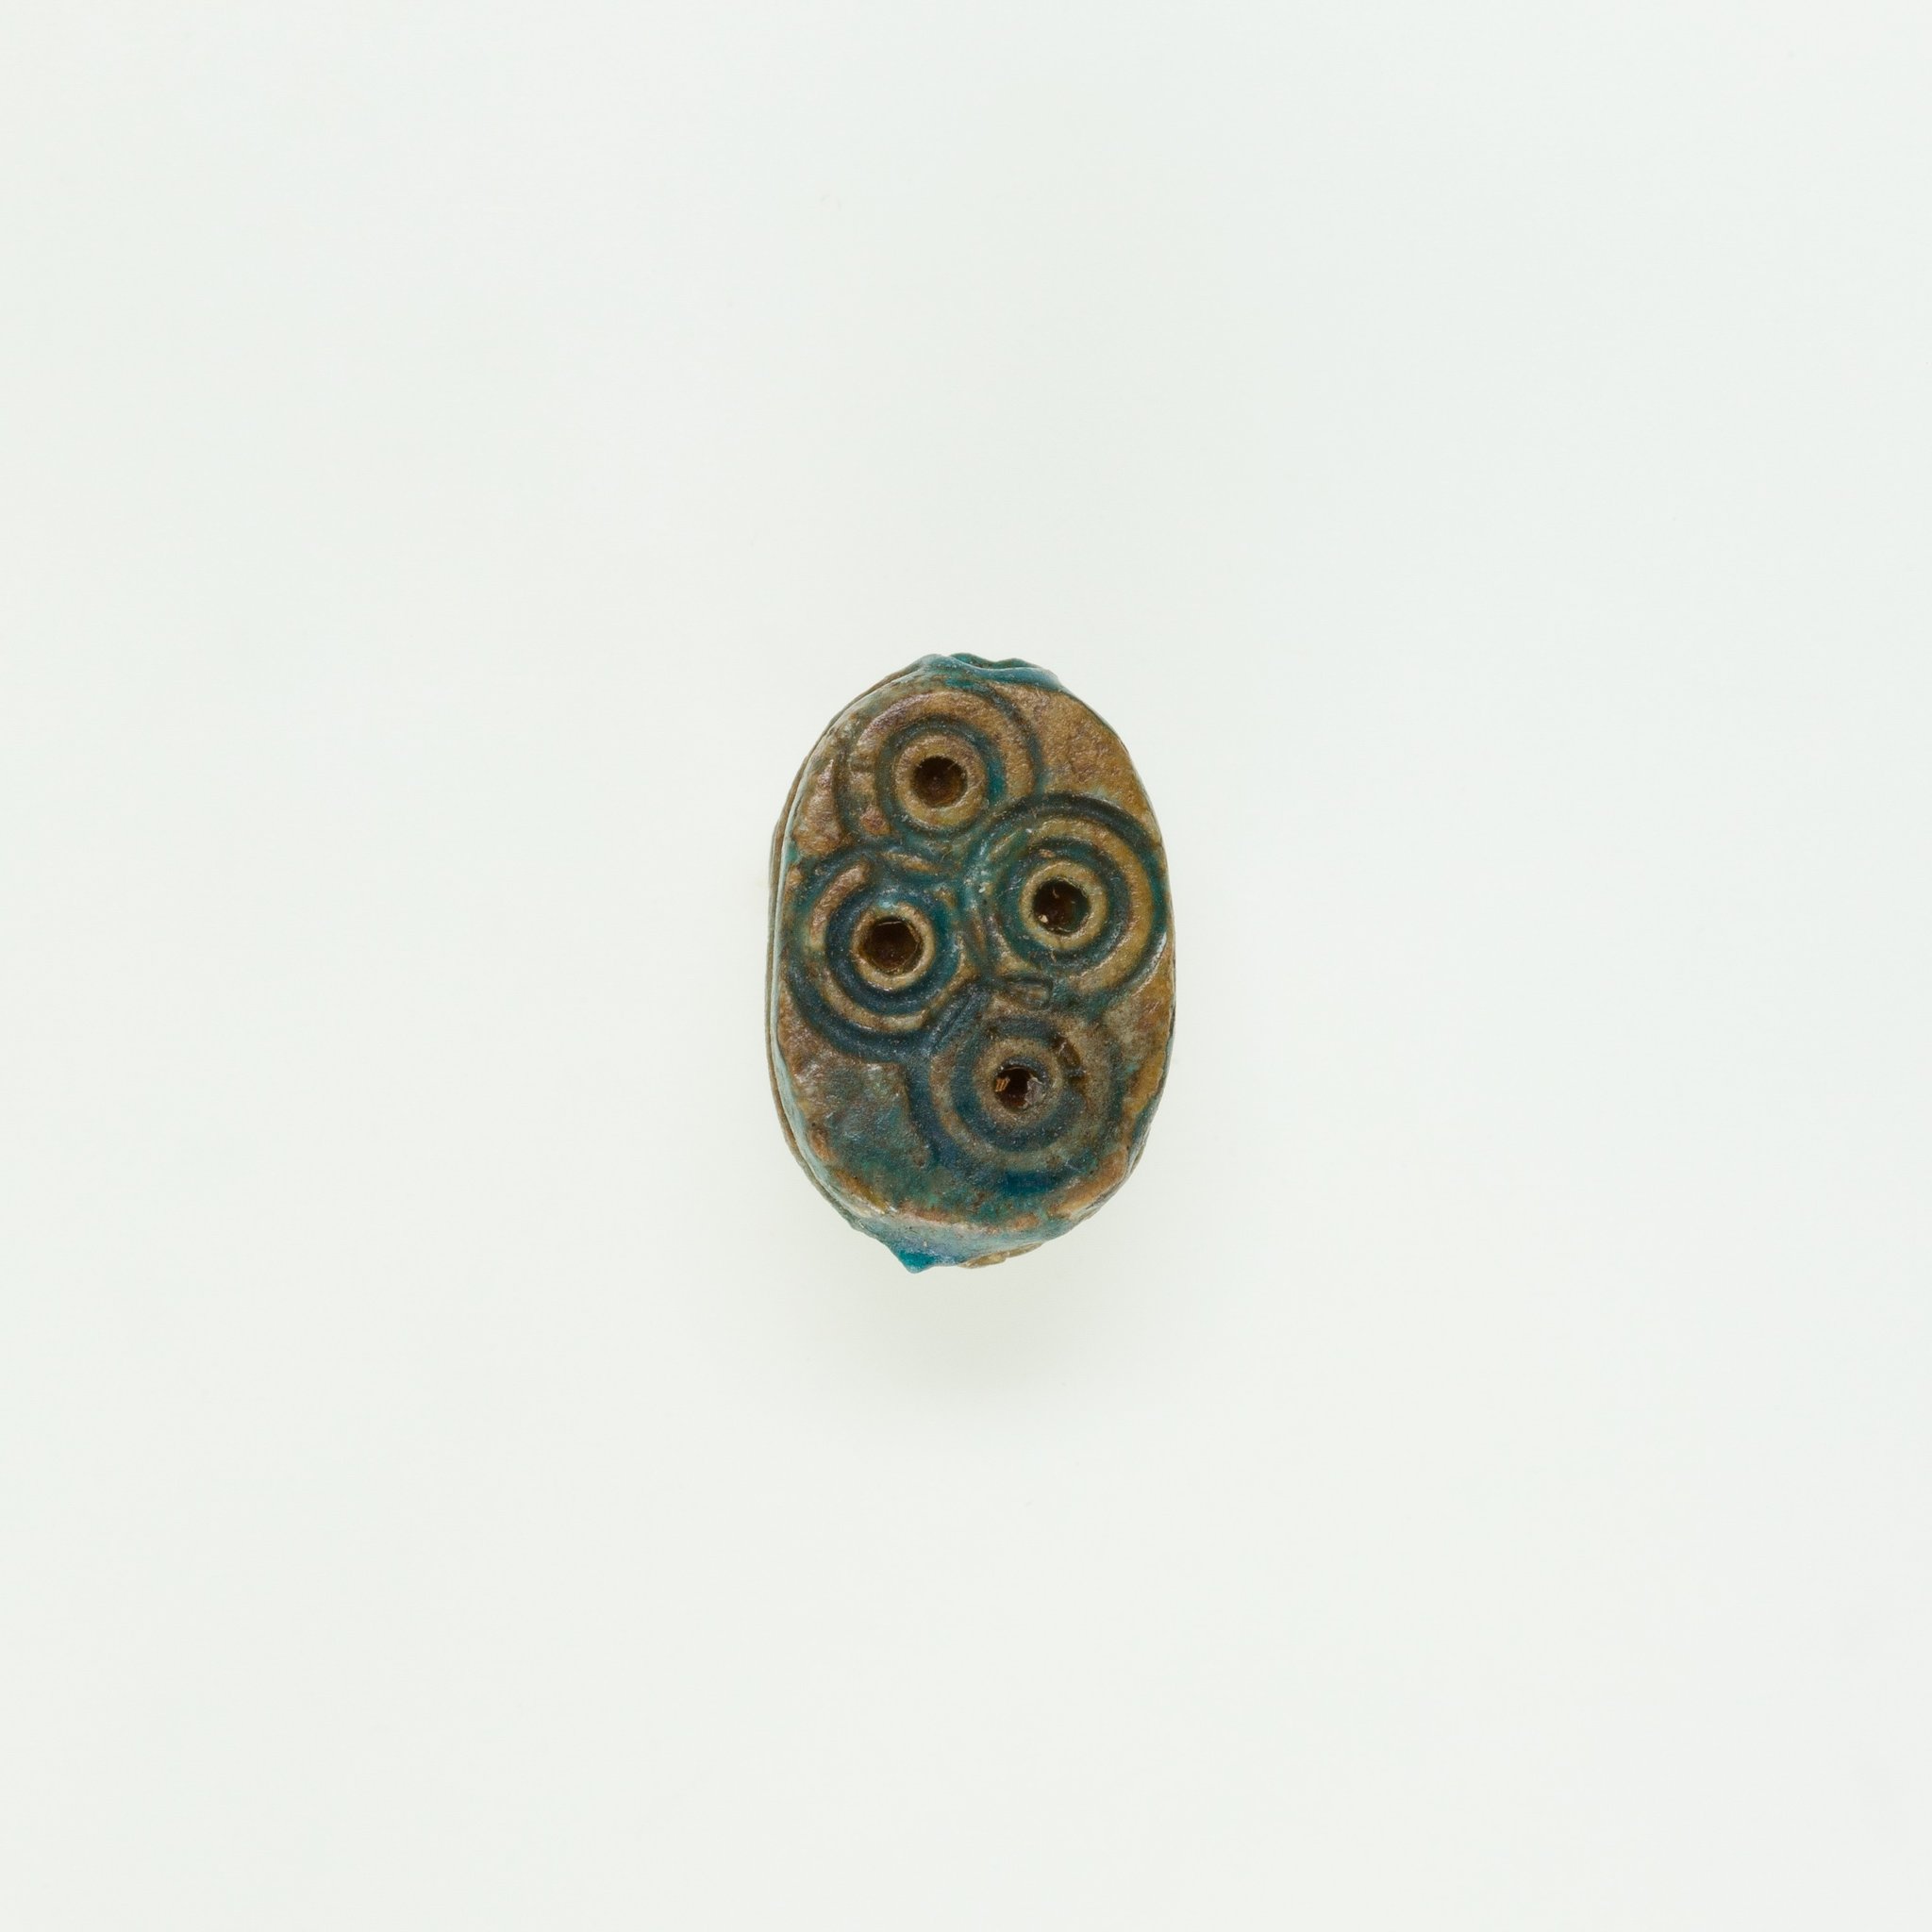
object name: scarab, circle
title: Scarab Decorated with Circles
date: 1640-1550 BCE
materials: stone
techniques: glazing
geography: egypt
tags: scarabs